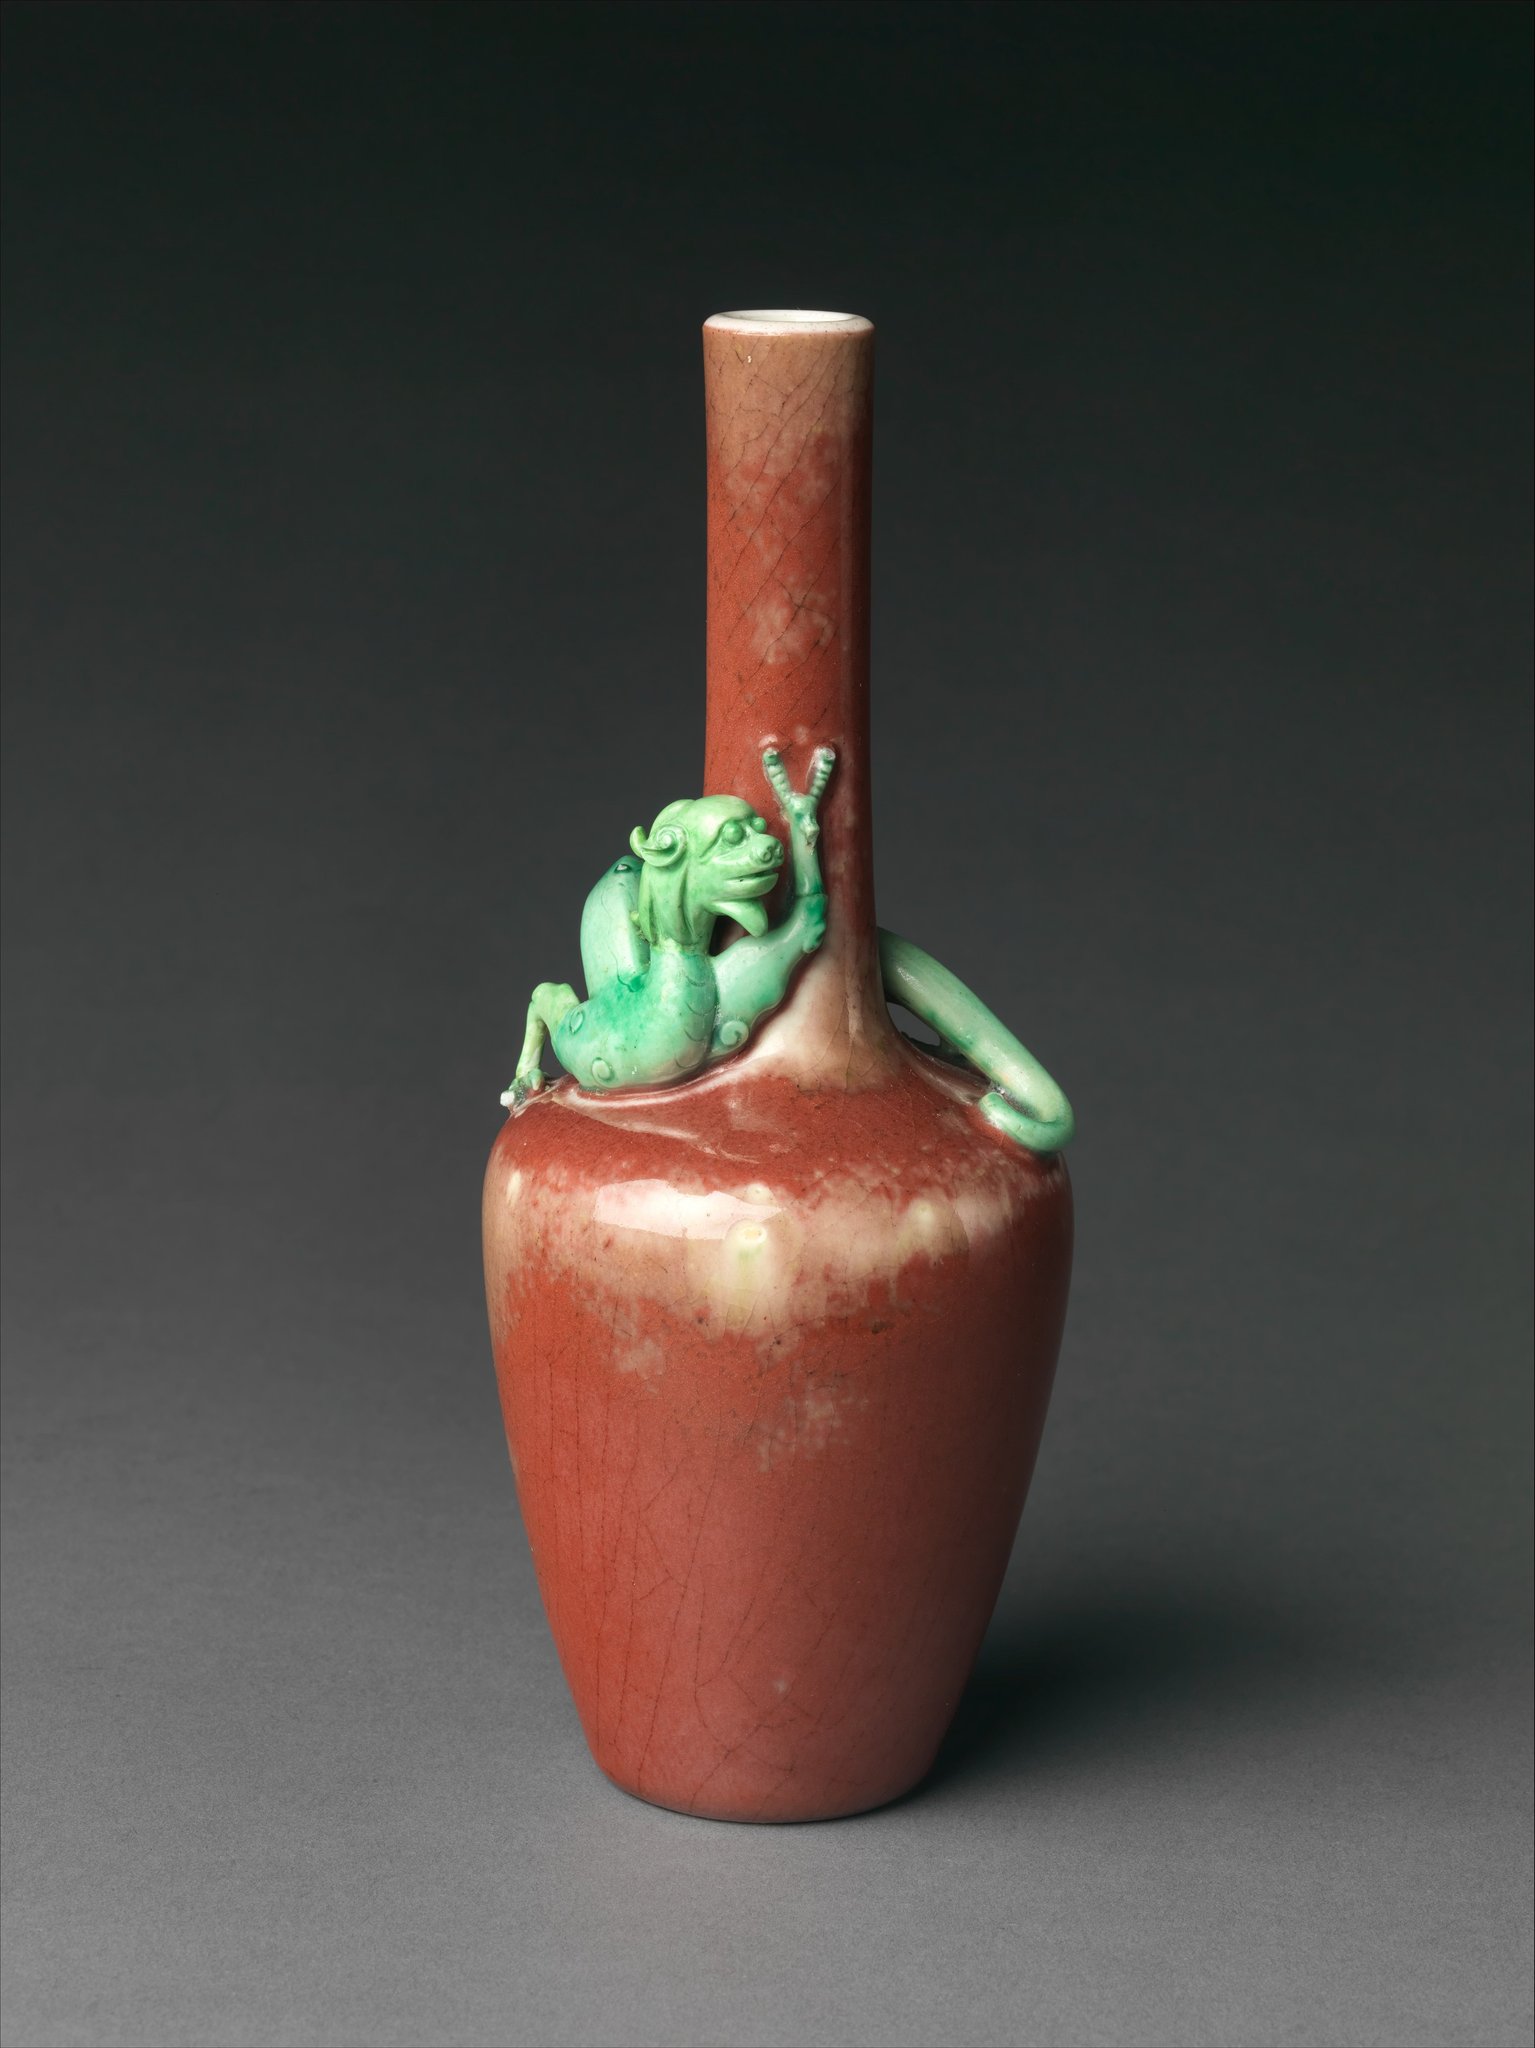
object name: vase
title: Vase with Coiling Dragon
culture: chinese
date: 1567-1633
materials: glaze, porcelain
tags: dragons